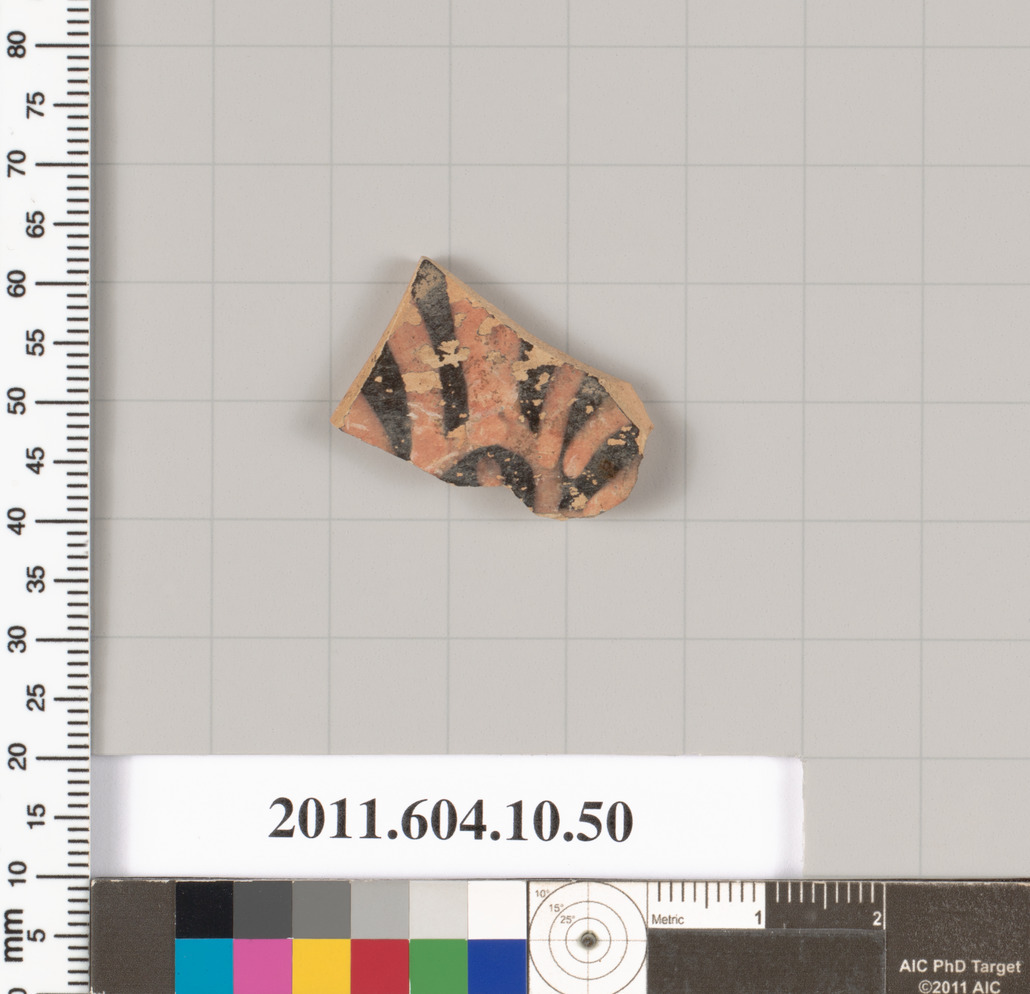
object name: kylix fragment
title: Terracotta fragment of a kylix (drinking cup)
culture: etruscan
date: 334-301 BCE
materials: terracotta